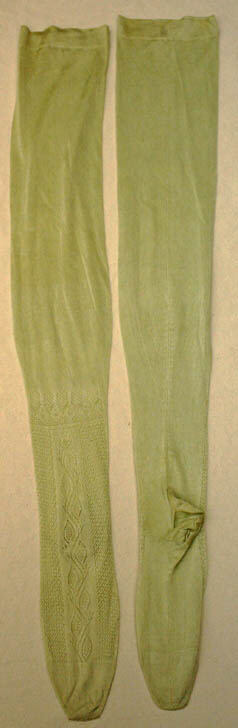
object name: stocking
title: Stockings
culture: french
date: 1801-1900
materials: silk